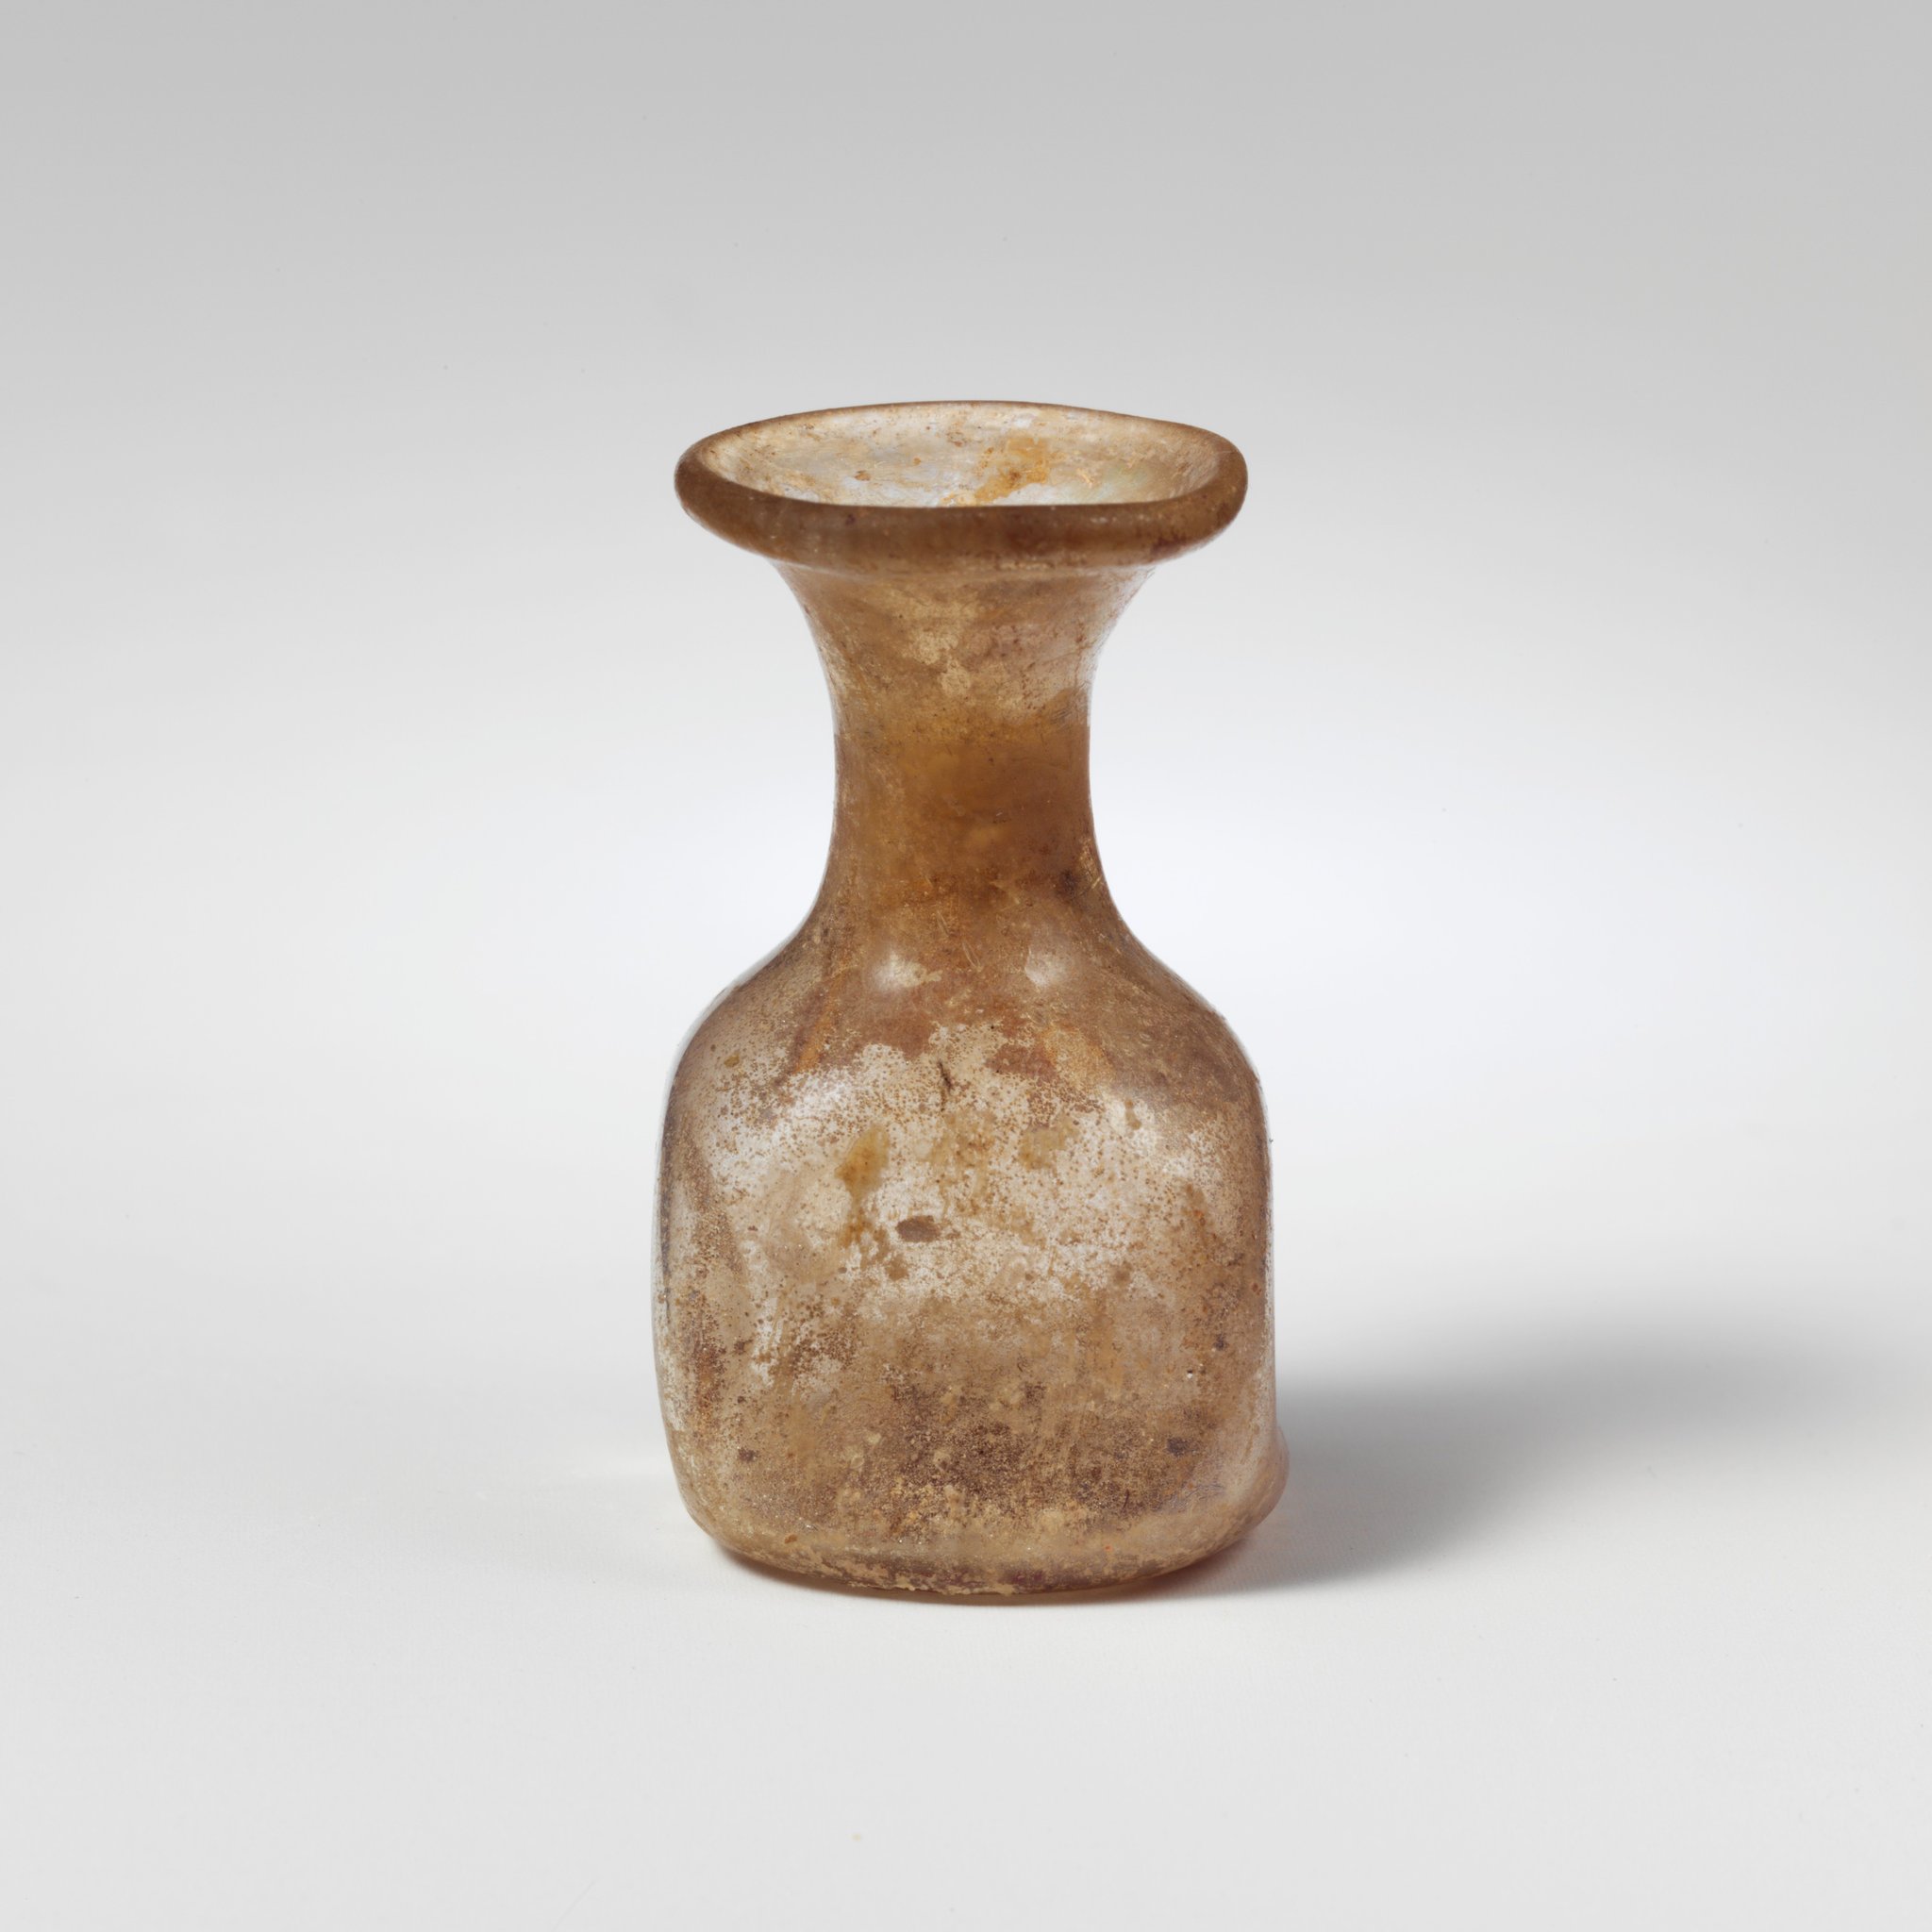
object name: bottle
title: Glass perfume bottle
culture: roman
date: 101-300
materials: glass